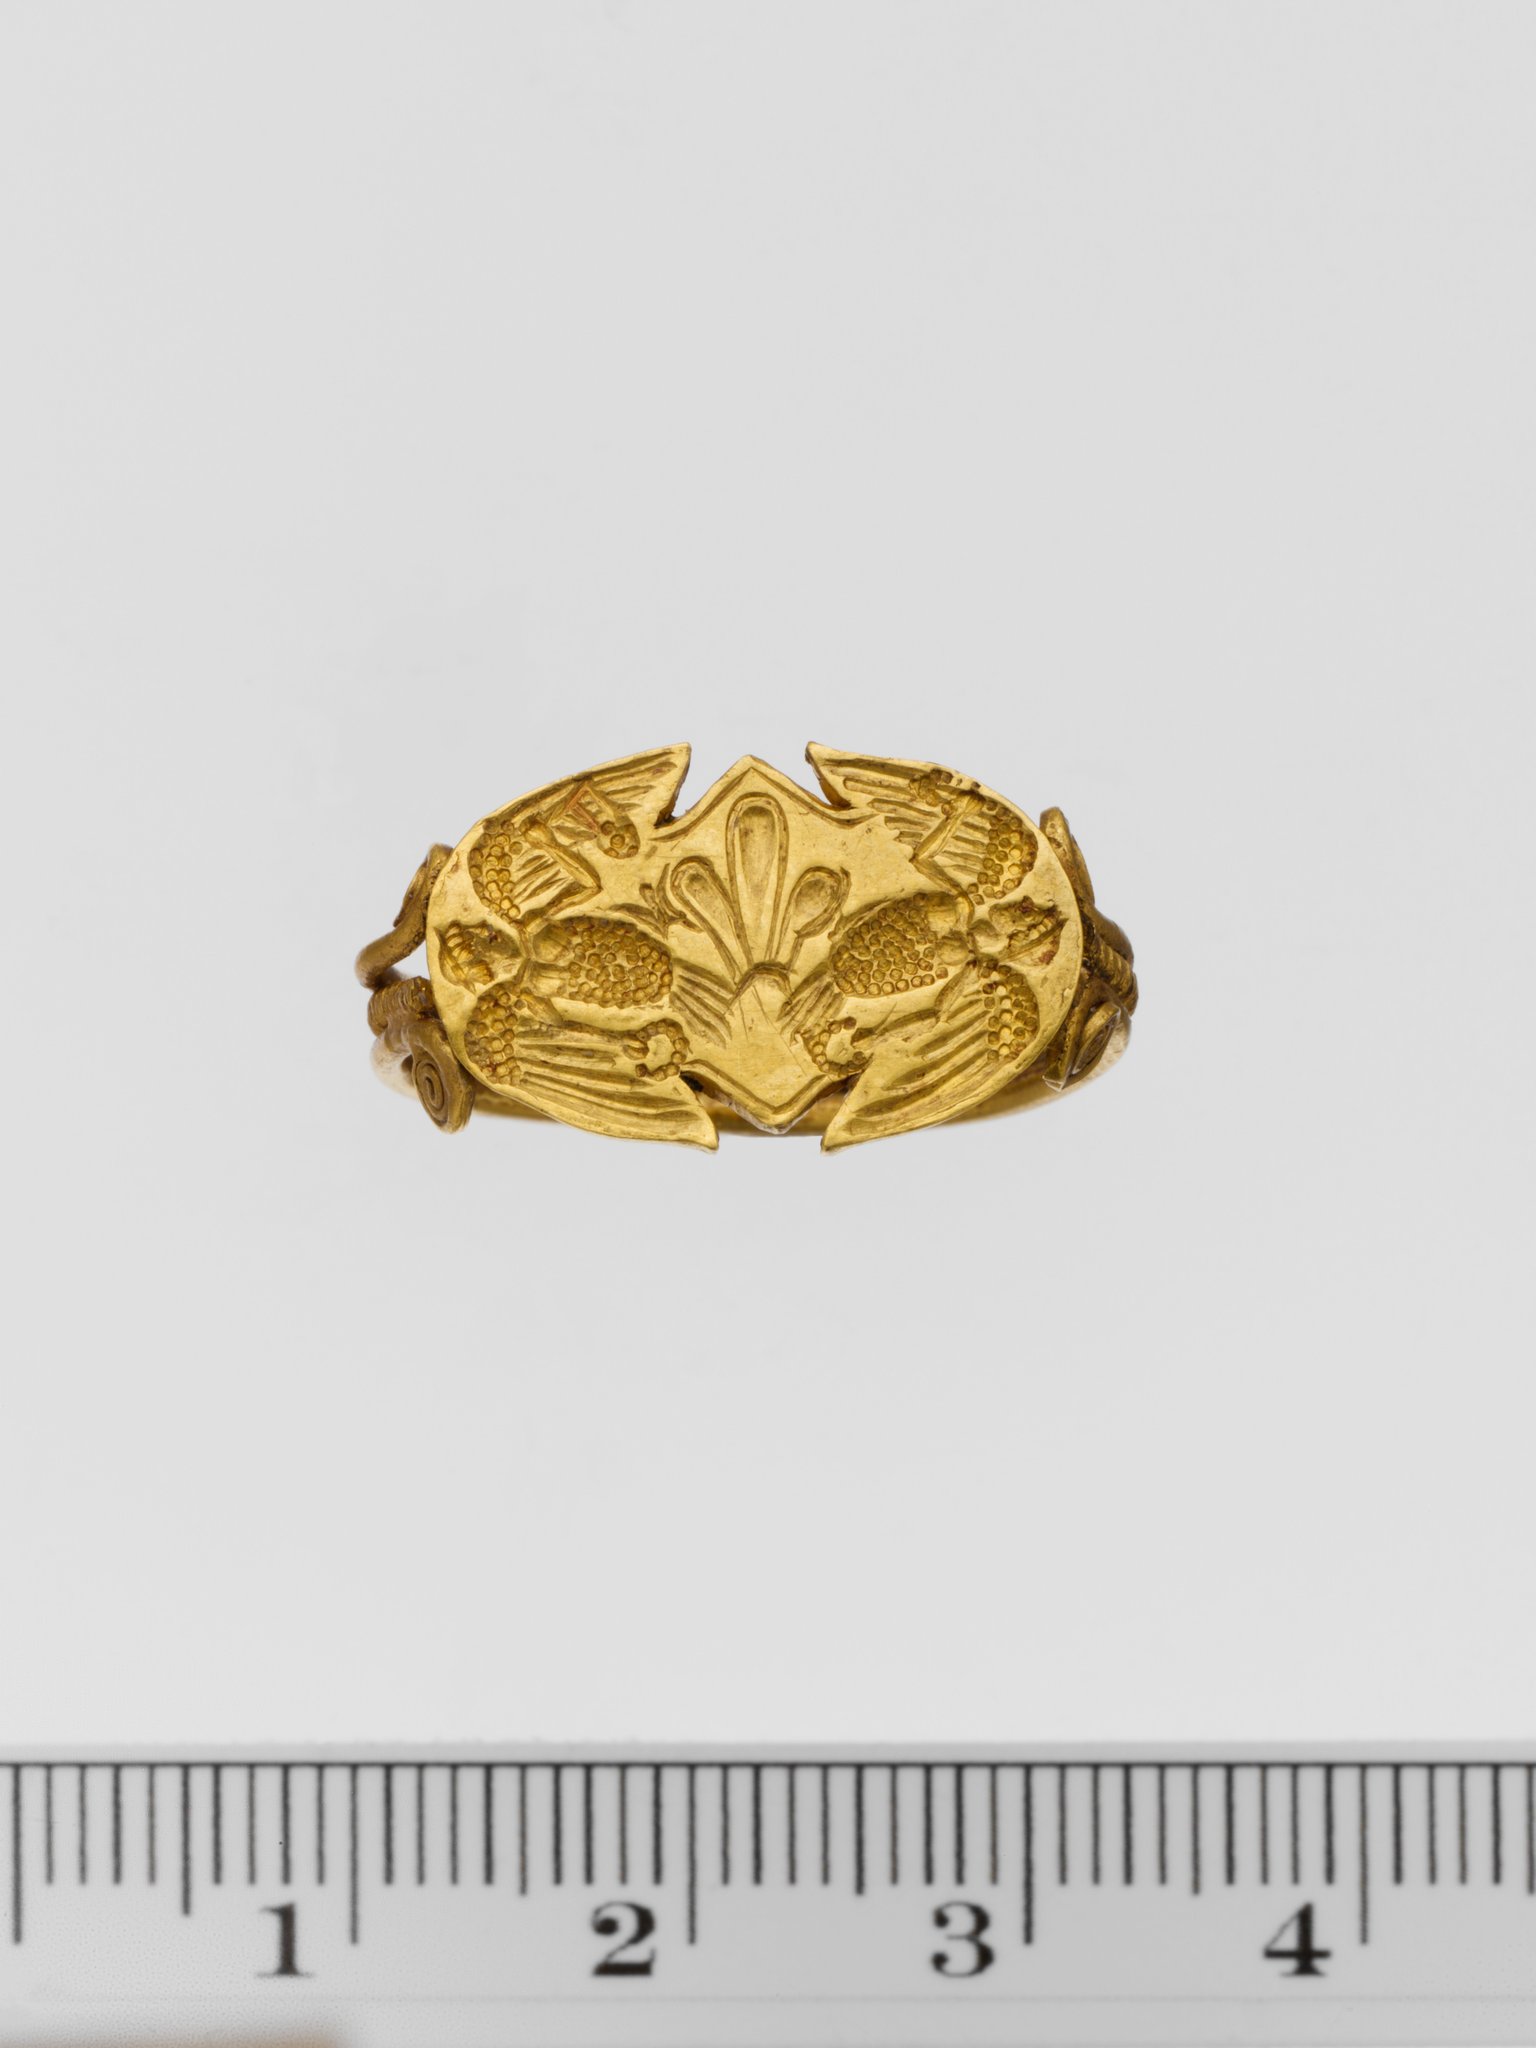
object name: ring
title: Gold ring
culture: cypriot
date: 534-468 BCE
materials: gold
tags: sirens